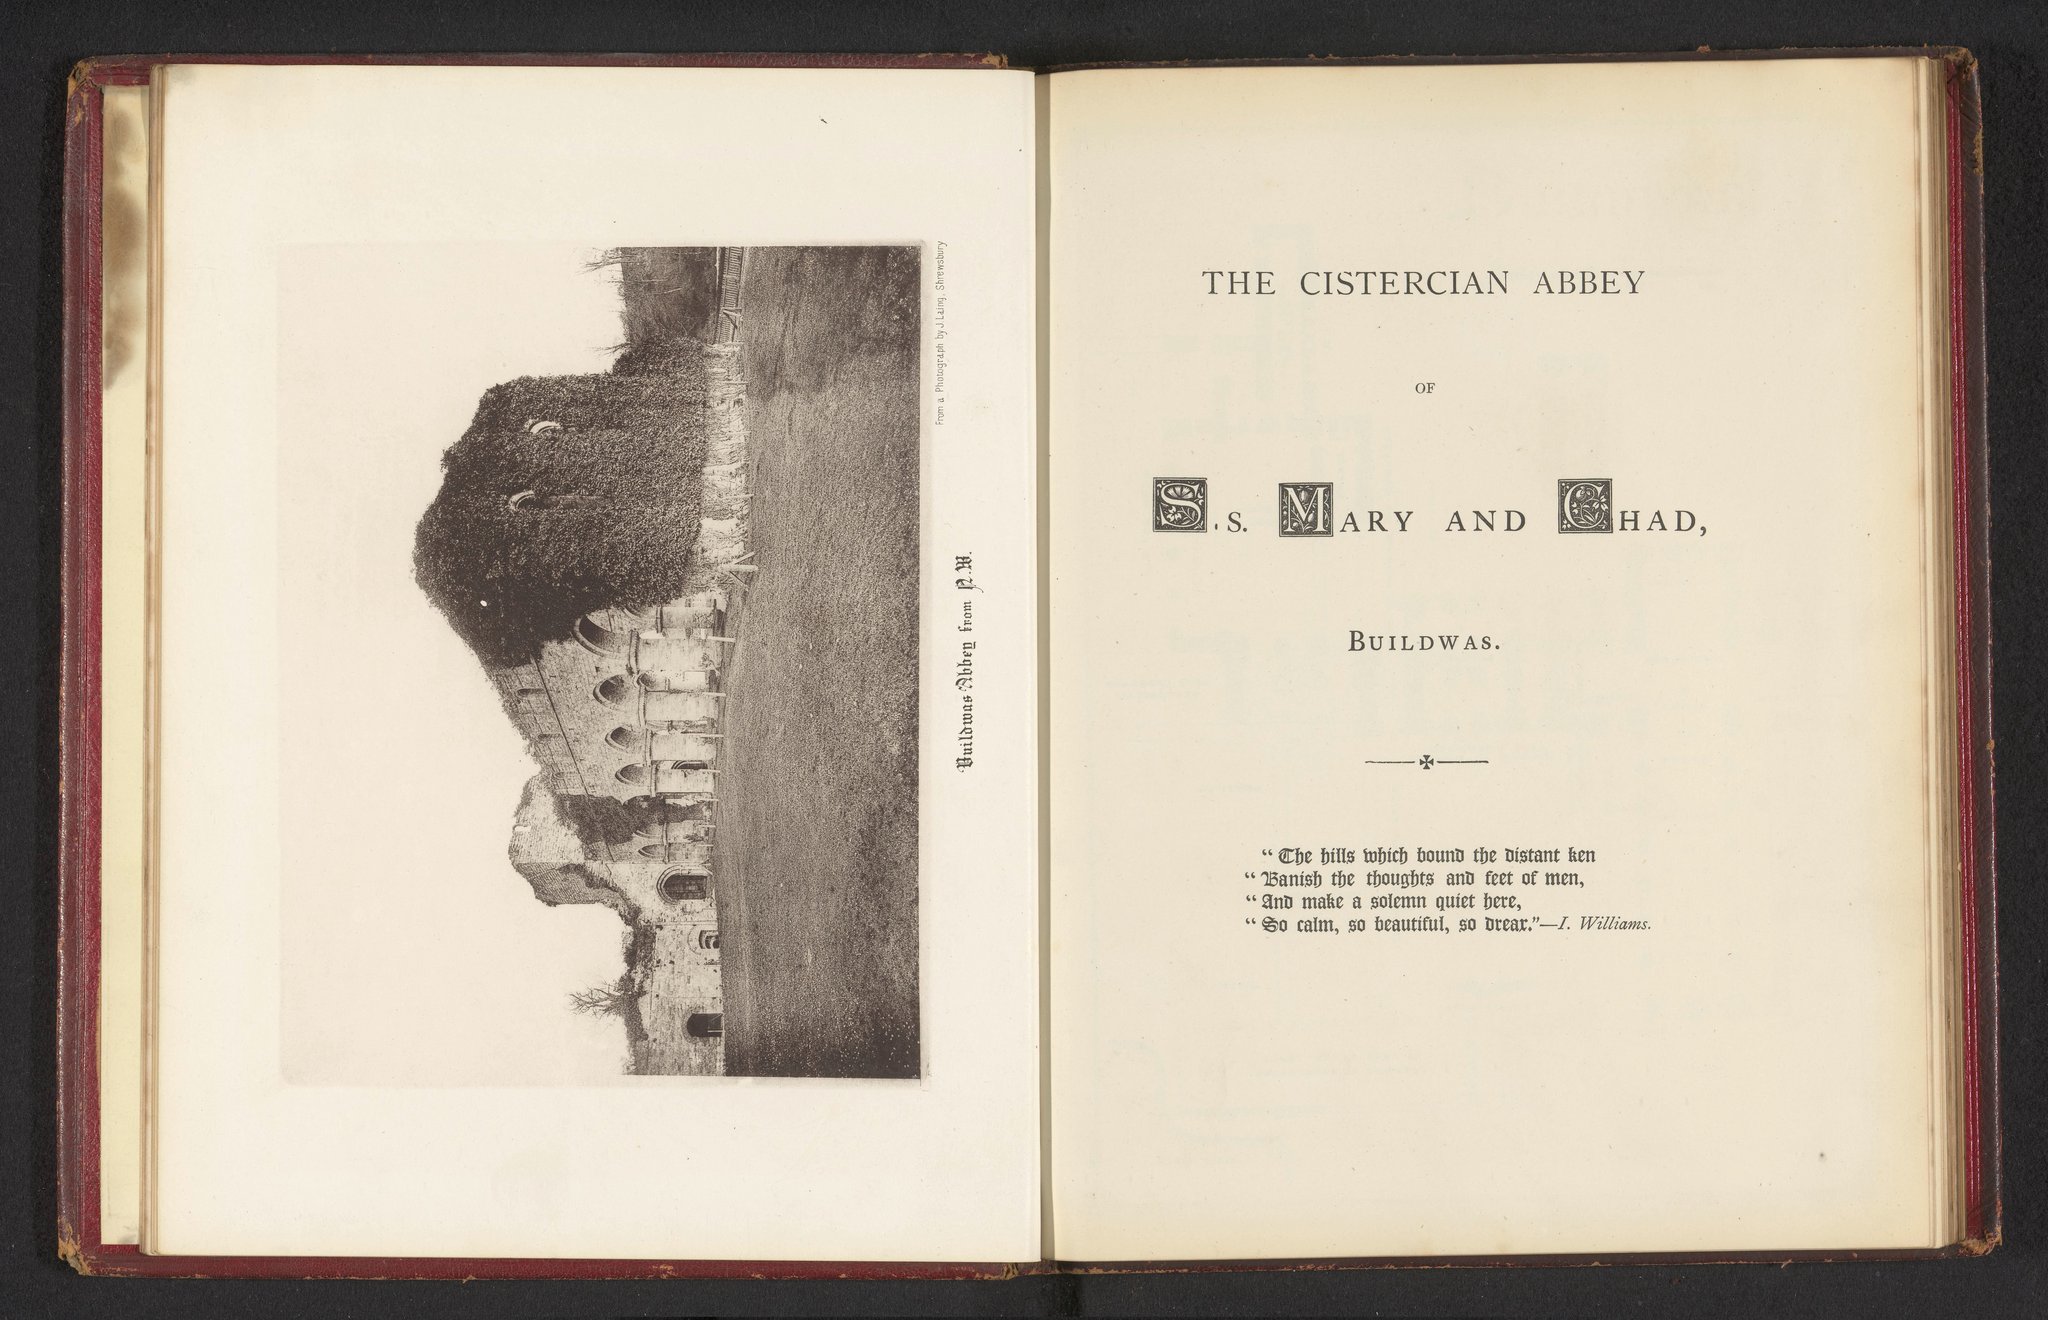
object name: photomechanical print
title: Buildwas Abbey from N.W.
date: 1867-1877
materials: paper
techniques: photograph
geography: buildwas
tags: ruin of church, monastery, etc.